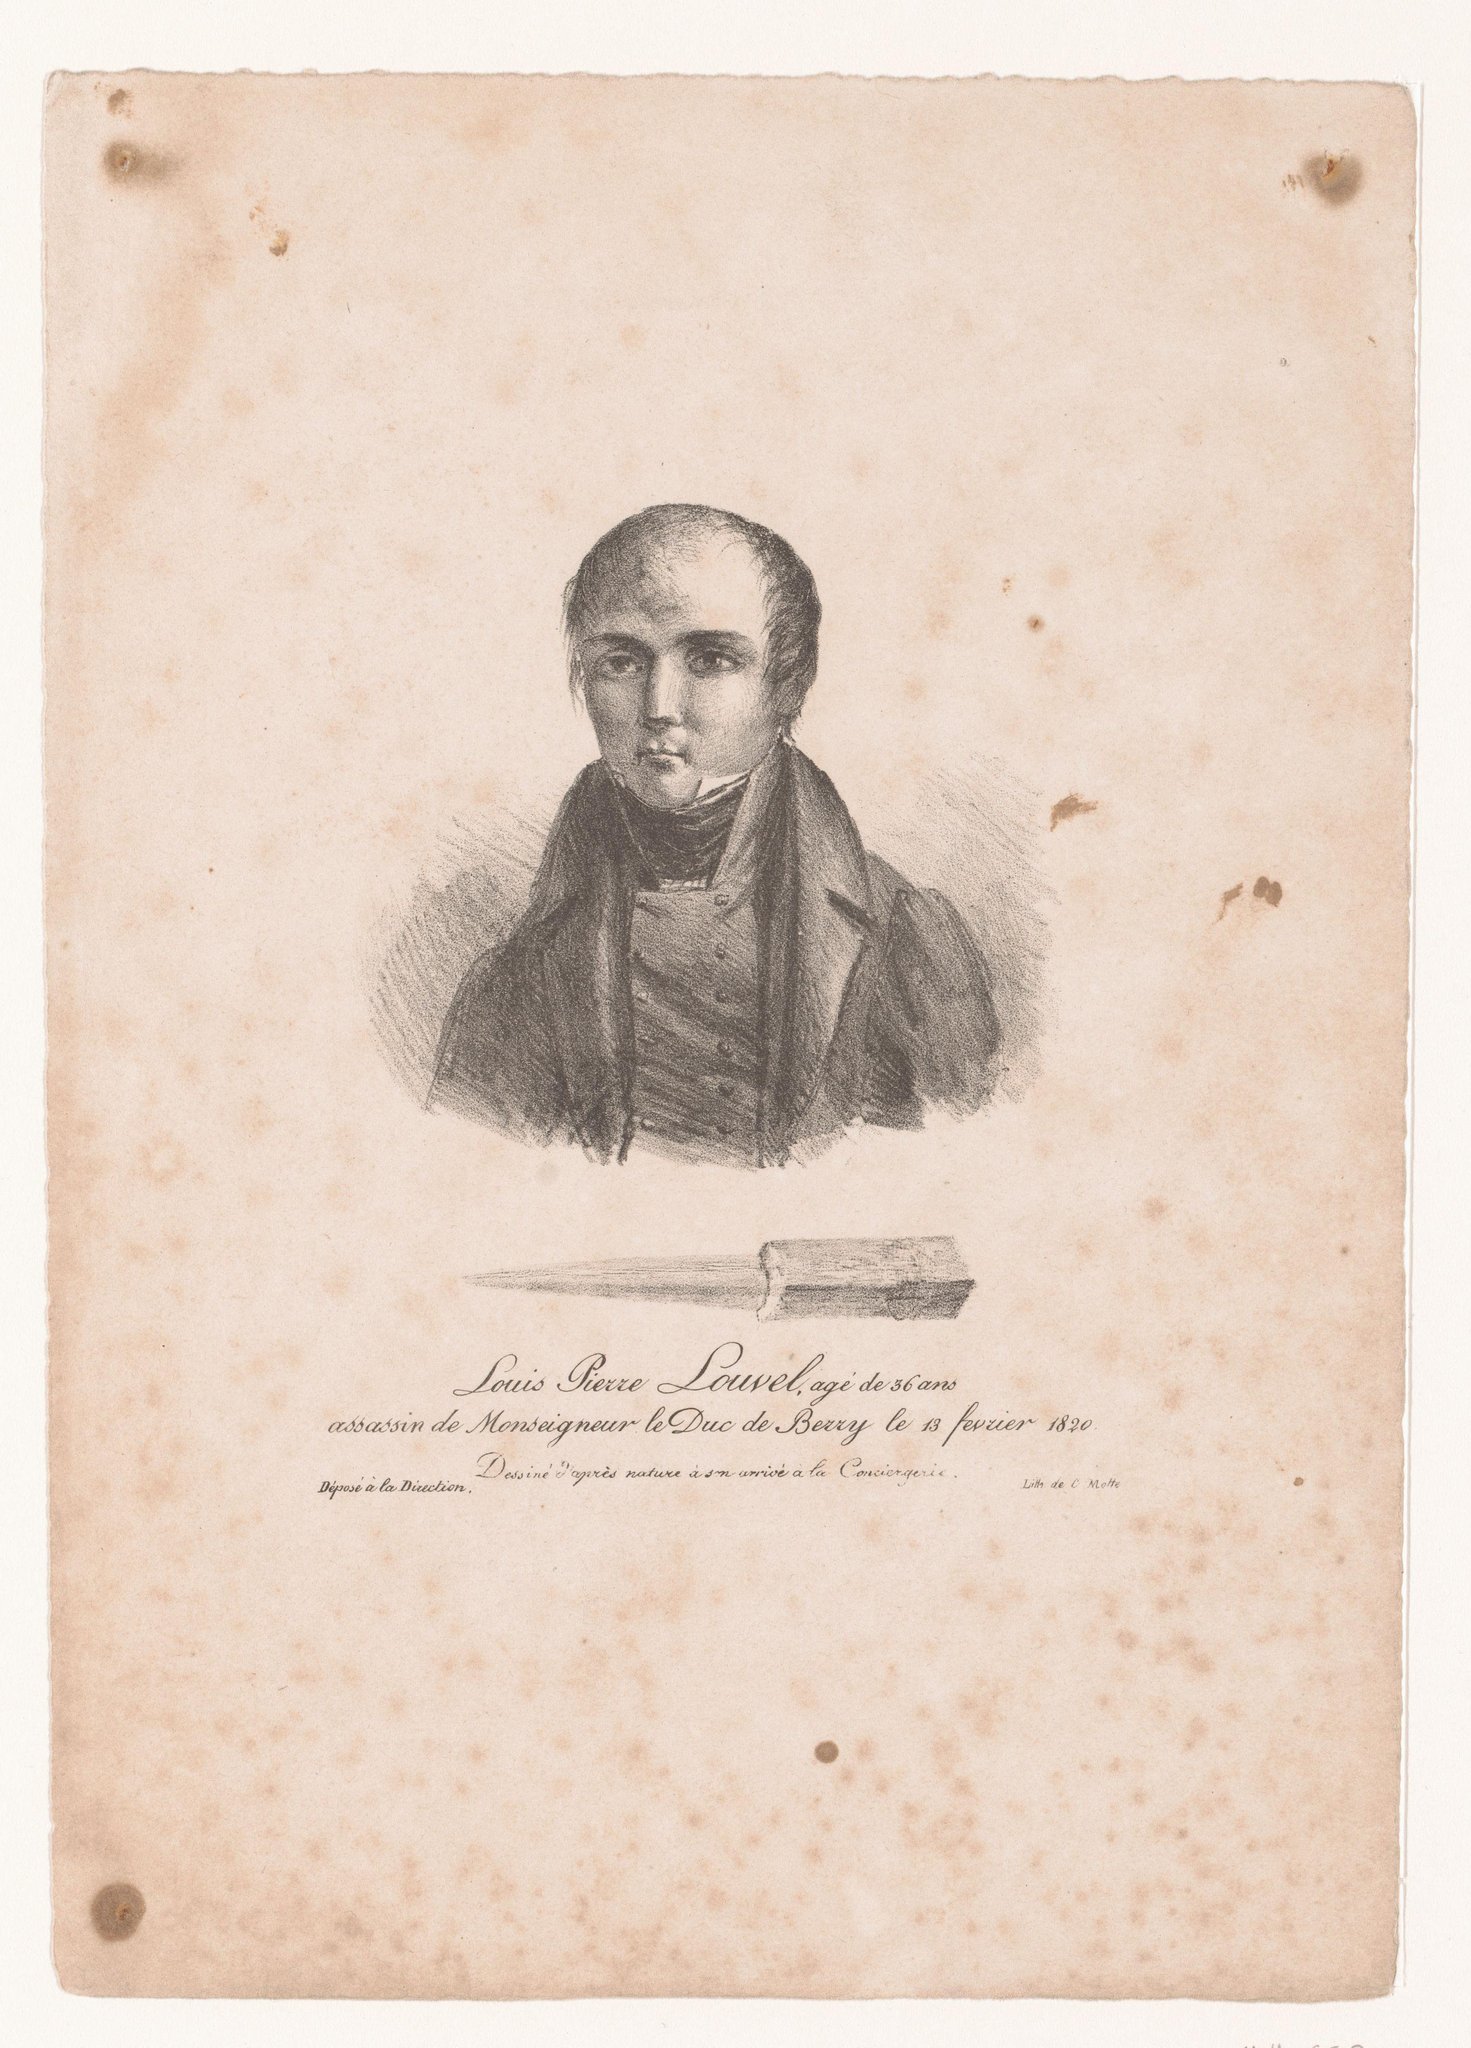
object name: print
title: Louis Pierre Louvel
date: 1820-1837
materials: paper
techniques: lithograph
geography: paris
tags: paris, historical persons, weapons, murderer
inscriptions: collector's mark: Lugt 2233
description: Onder het portret is het wapen afgebeeld waarmee hij Charles-Ferdinand d'Artois, hertog van Berry vermoordde.